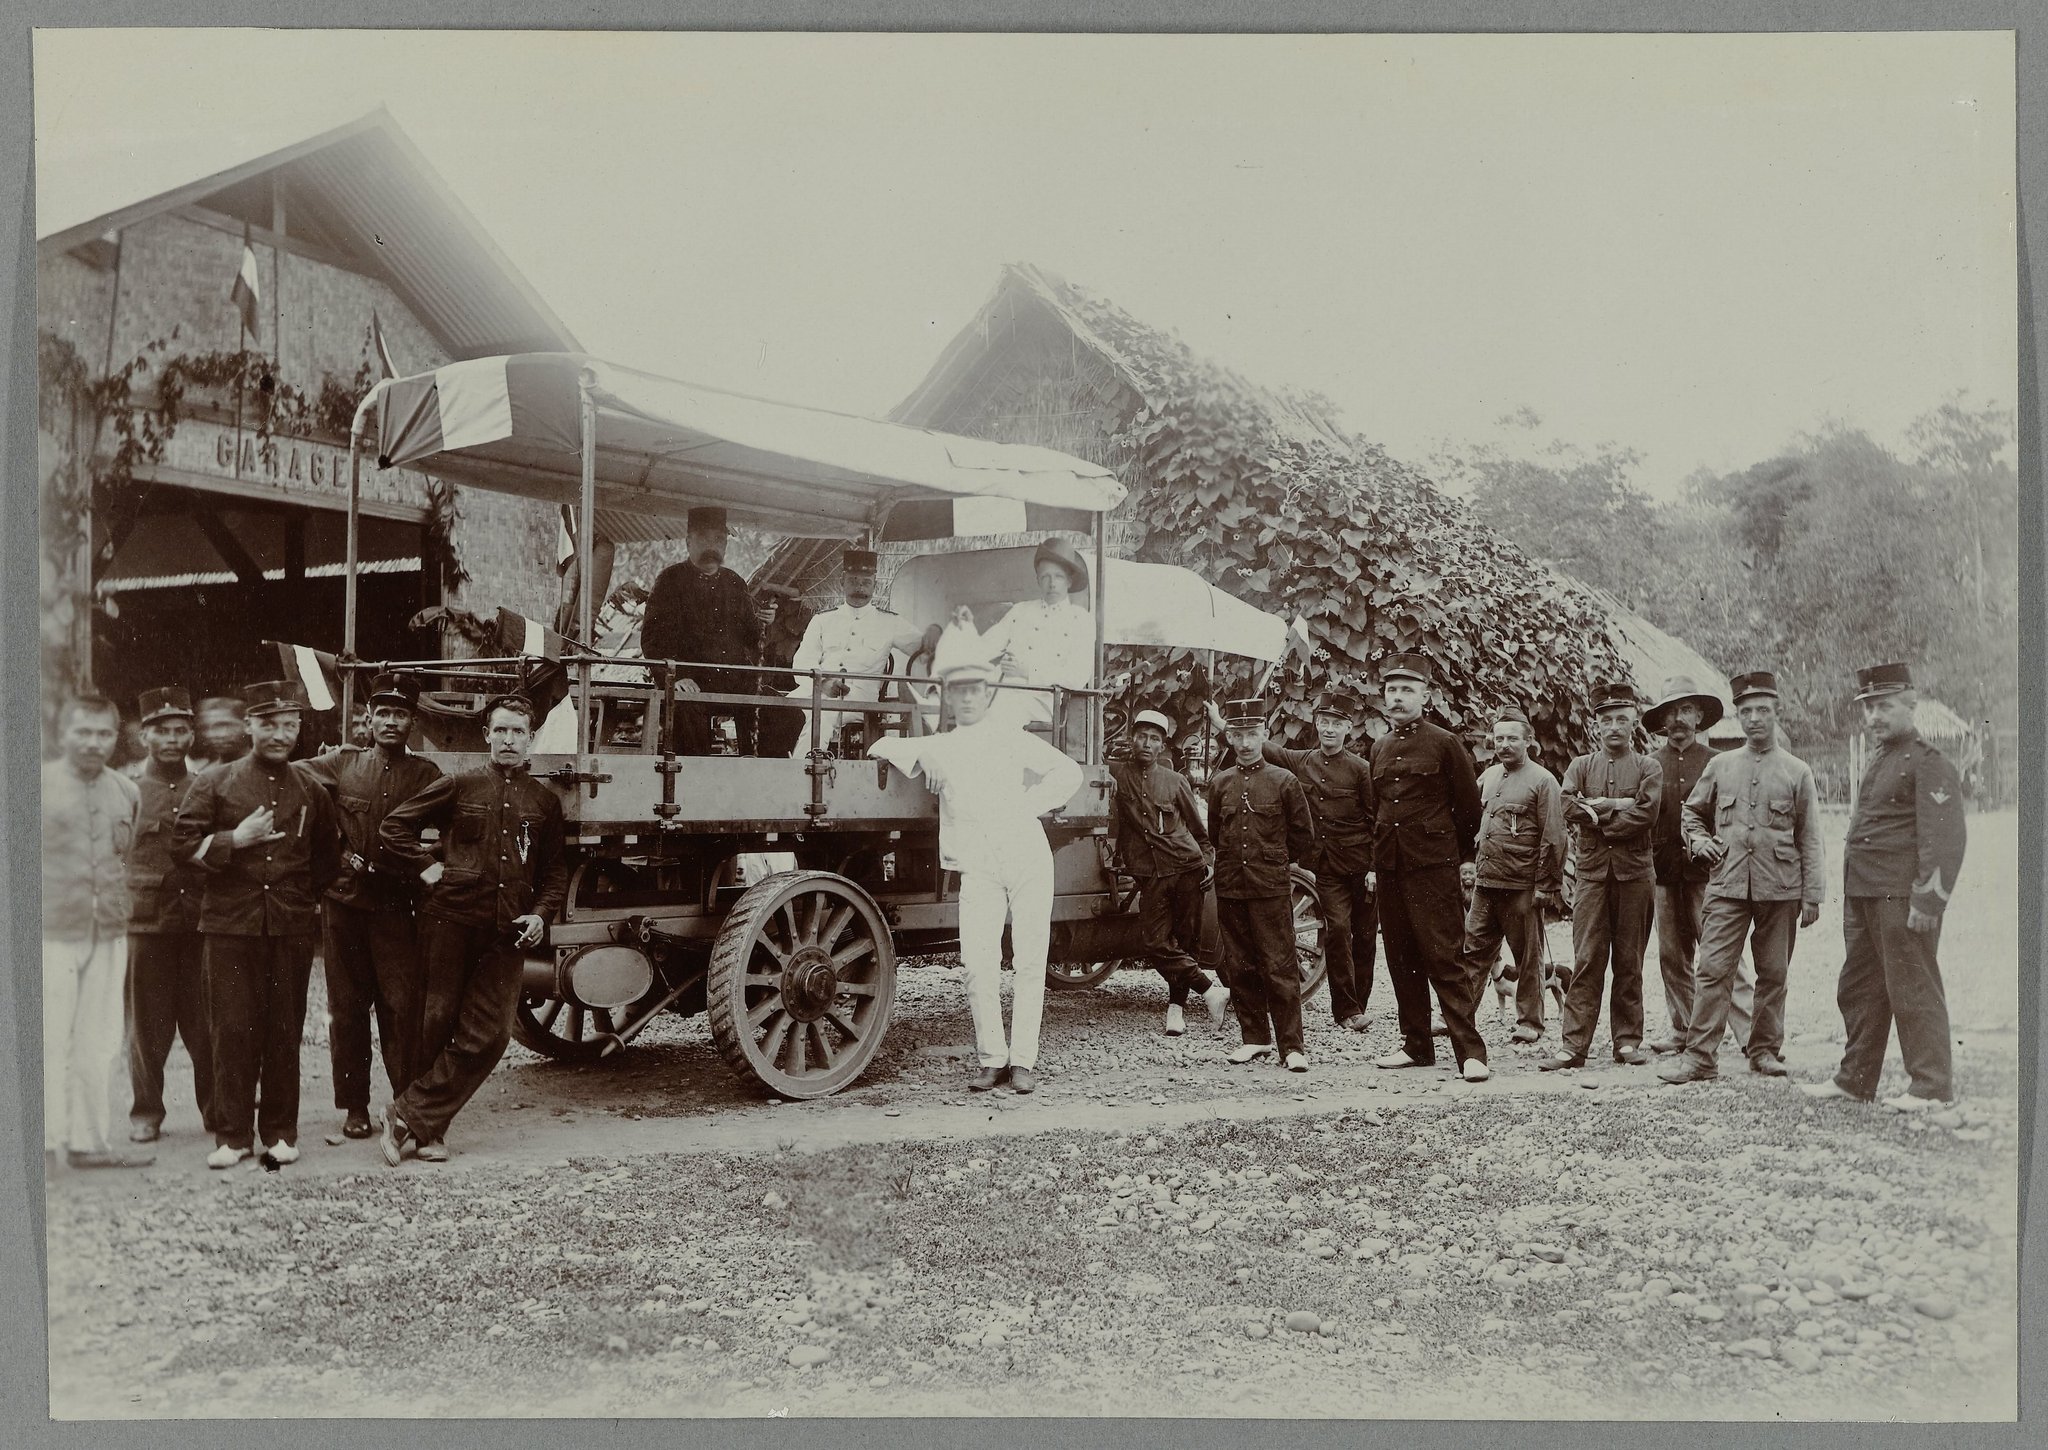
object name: photograph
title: Militairen bij een vrachtauto te Krueng Seumpo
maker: Anonymous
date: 1903-1913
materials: photographic support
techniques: photography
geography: north sumatra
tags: arnhem, albertus dominicus laman trip, truck, van, traffic by road or path with motor-vehicle, landscapes in tropical and sub-tropical regions, village, road, path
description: Na de expedities naar de Gajo- en Alaslanden o.l.v. Van Daalen (eerste tocht in 1901), werd hij in 1903 belast met voorbereiding van permanente vestiging van Nederlands gezag. Aanleg van een weg van de Noordkust naar het binnenland was hierbij van groot belang. Deze zgn. Gajoweg werd aangelegd tussen 1903 en 1914, van Bireuen aan de kust naar Takinguen aan het bergmeer Danau Lauttawar, totale lente 104 km.